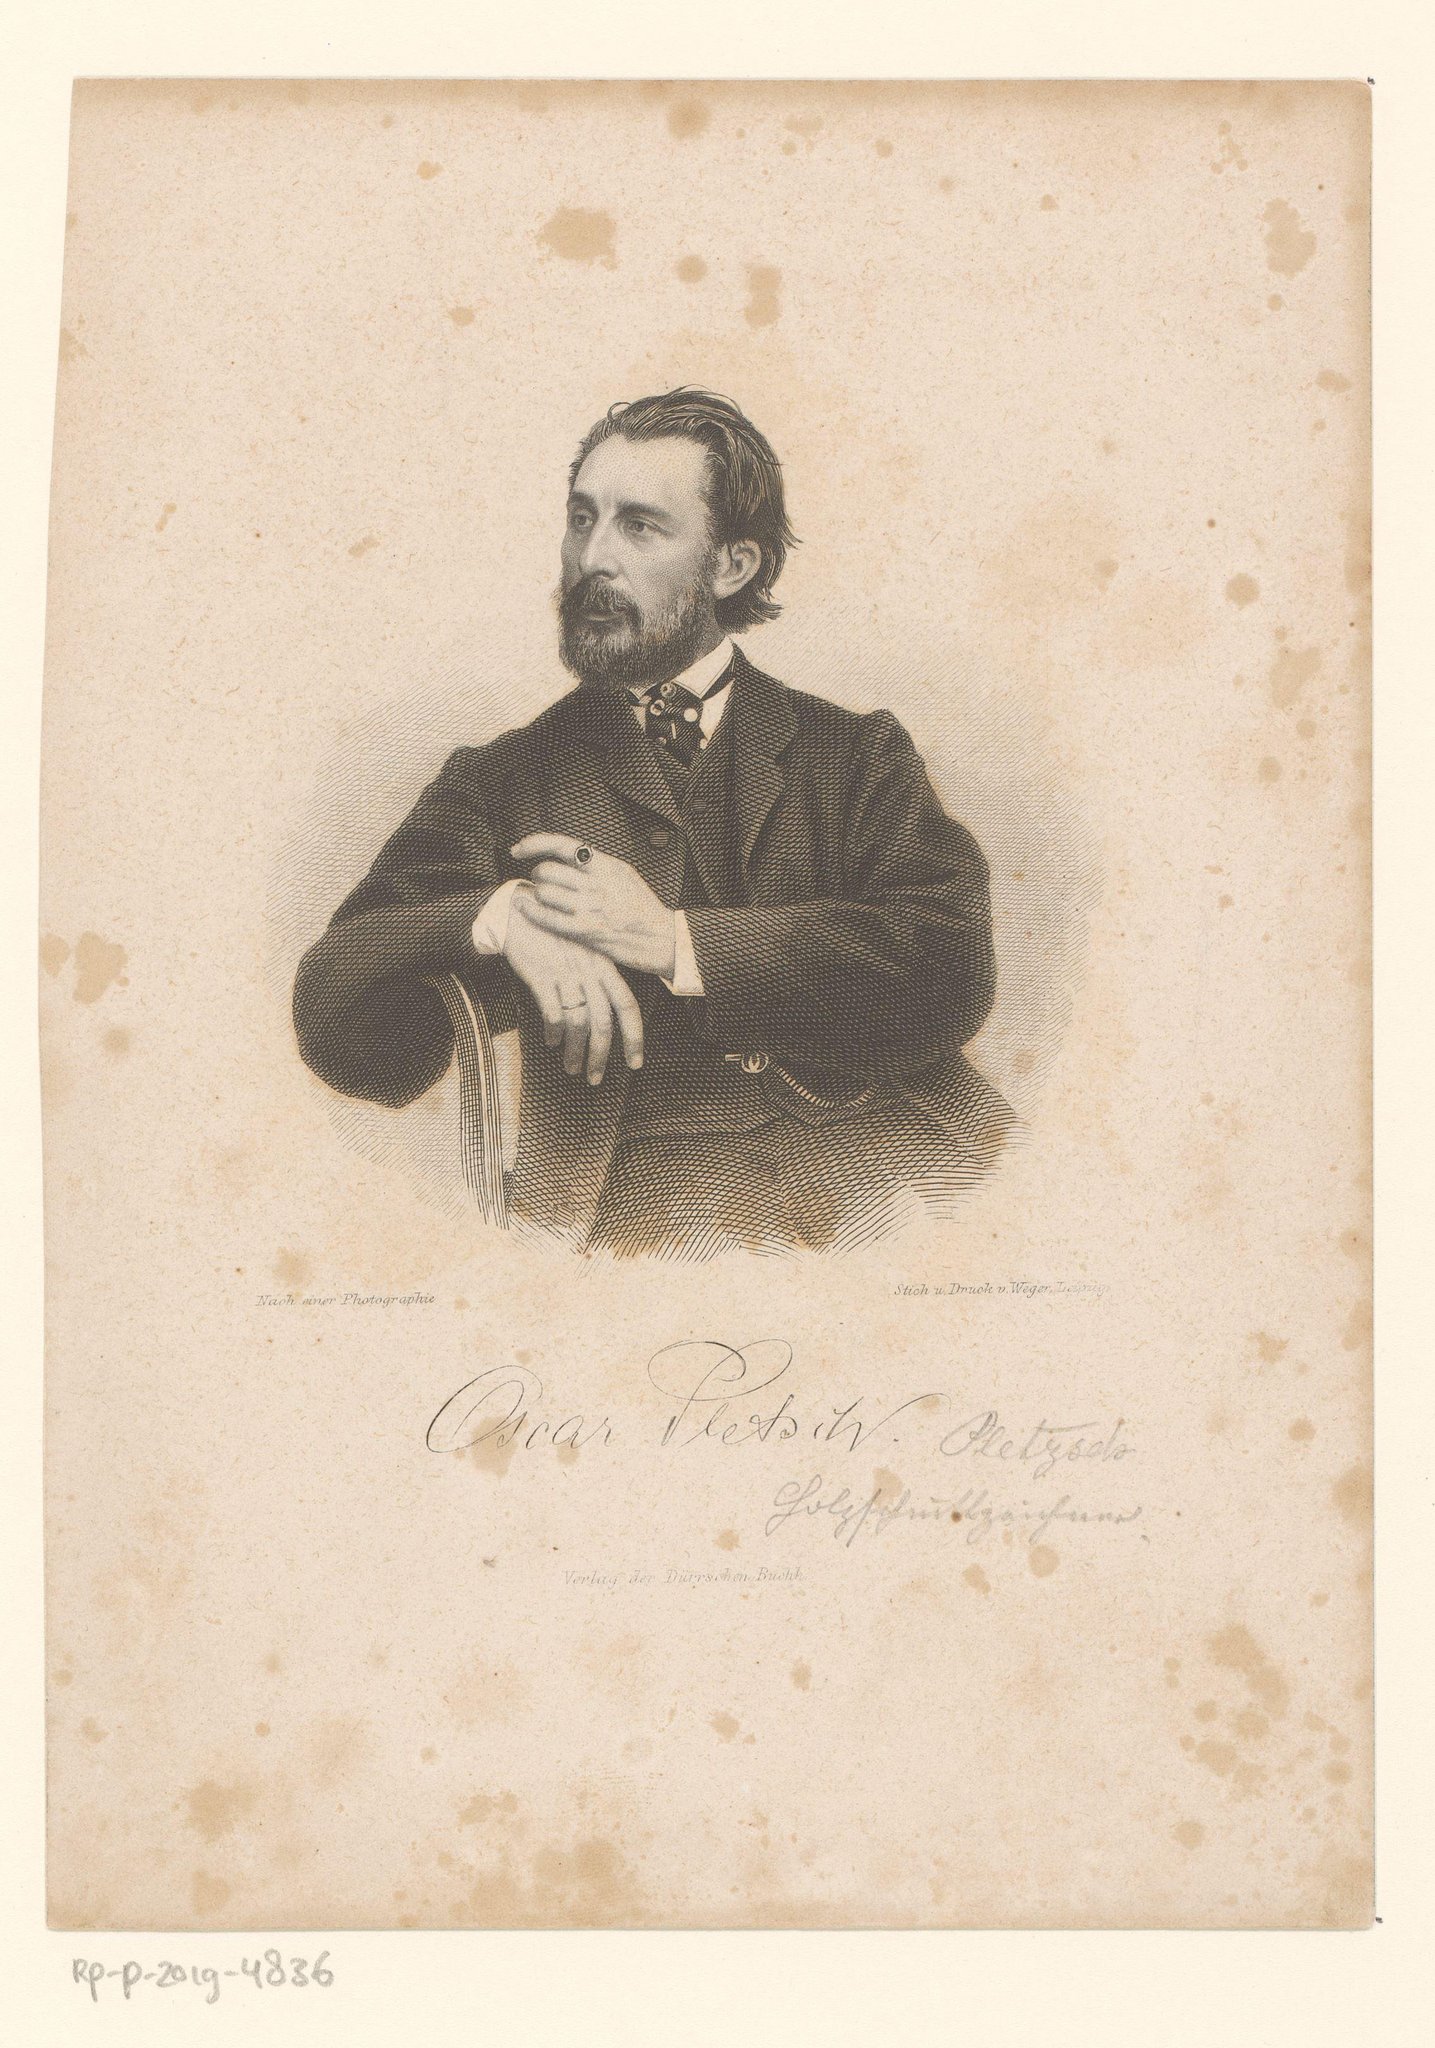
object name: print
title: Portret van Oscar Pletsch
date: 1878-1892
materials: paper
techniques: etching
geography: leipzig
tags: painter, oscar pletsch, historical persons, portrait, self-portrait of painter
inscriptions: collector's mark: Lugt 2760, collector's mark: Lugt 2228, collector's mark: ‘Franz Radestom [?]’